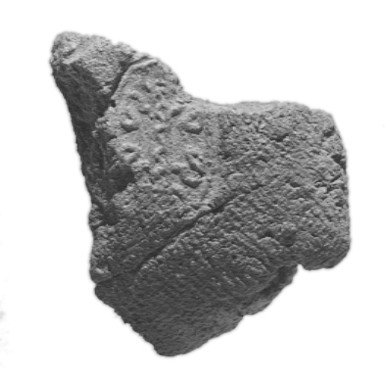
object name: sealing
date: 2030-1640 BCE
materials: clay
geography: egypt